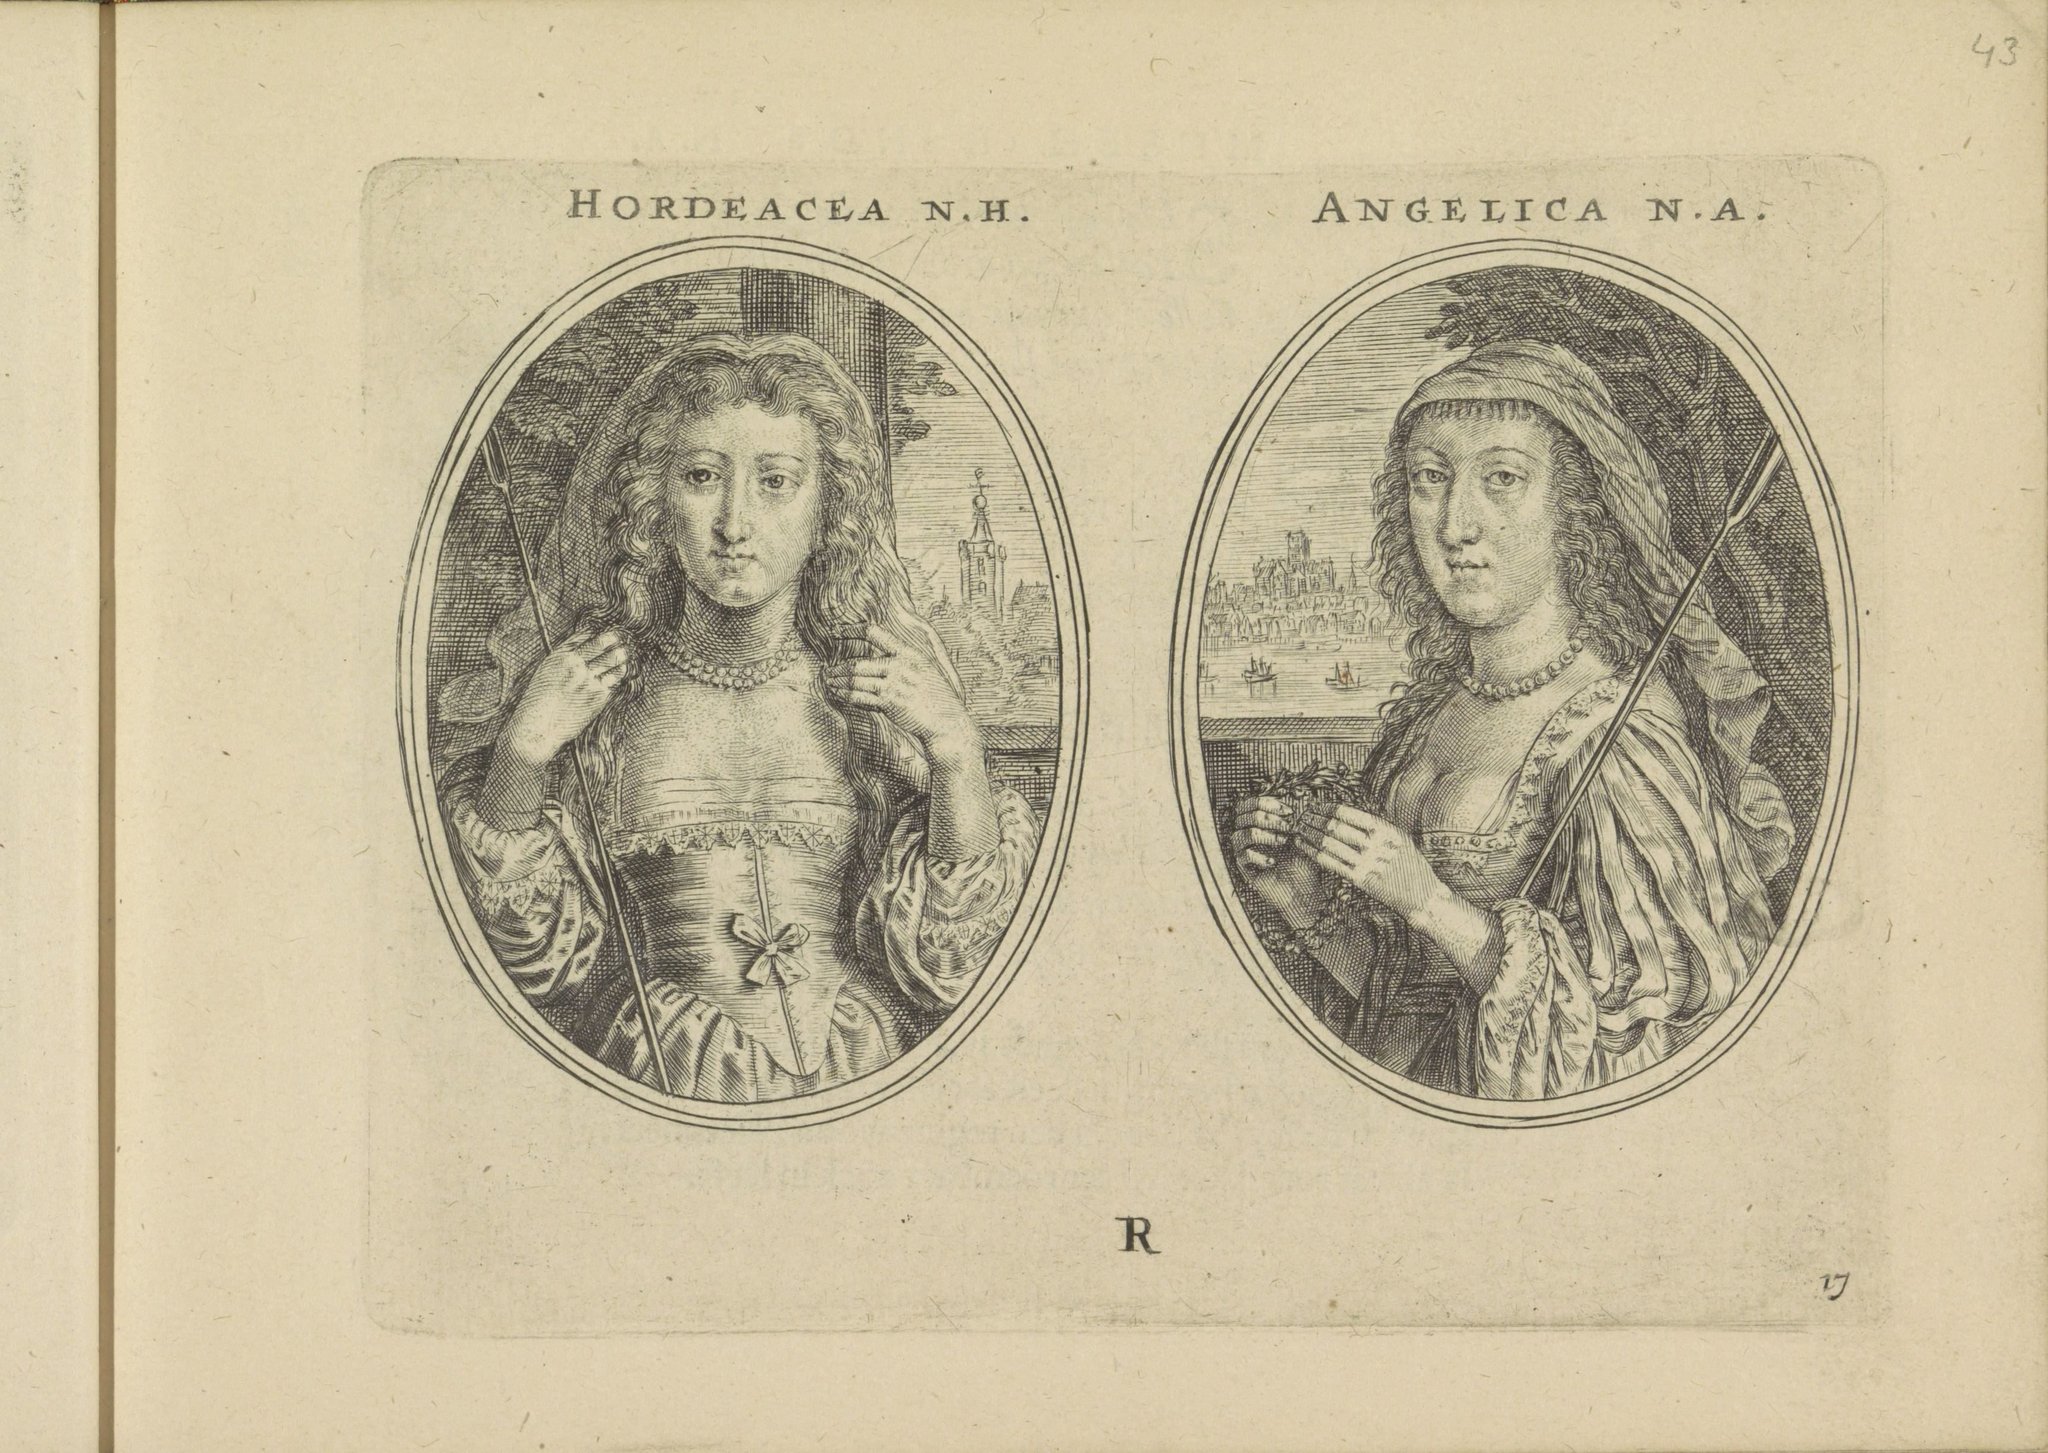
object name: album leaf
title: Hordeacea N.H. / Angelica N.A.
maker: crispijn van de passe (ii)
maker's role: draughtsman, print maker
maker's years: 1594-1670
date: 1640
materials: paper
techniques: engraving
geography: amsterdam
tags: female sex; woman, shepherd's crook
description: Twee voorstellingen op een albumblad. Portretten van twee onbekende vrouwen, met herdersstaf, als Hordeacea N.H. en Angelica N.A. Op de achtergrond respectievelijk een kerk en een stad aan het water. Onderaan genummerd: R en 17. Het blad maakt deel uit van een album.